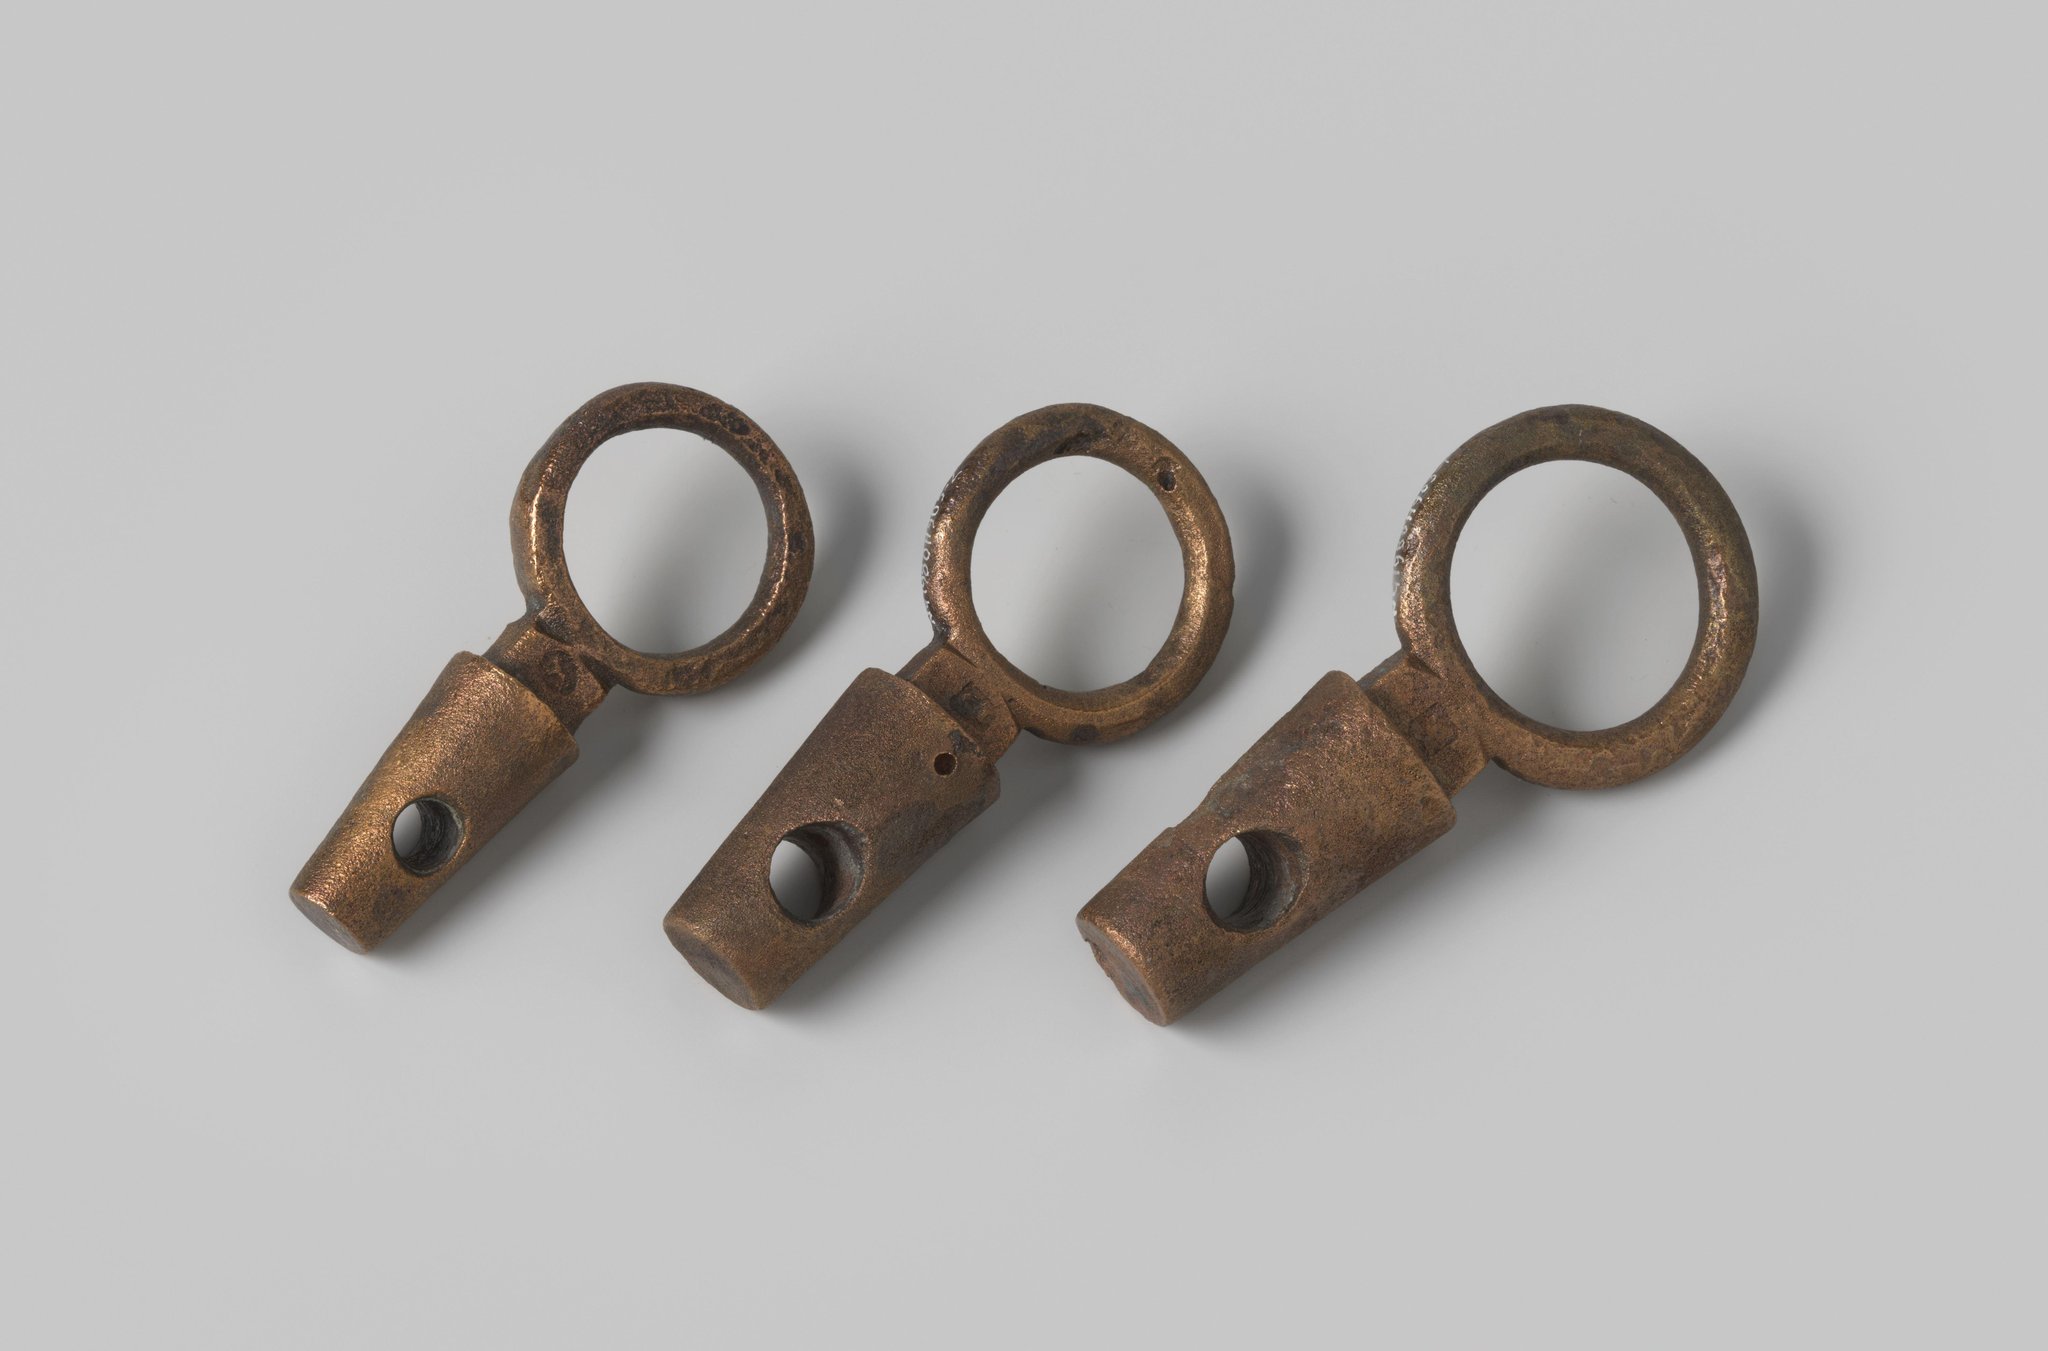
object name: spigot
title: Tapkranen uit het wrak van de Oost-Indiëvaarder Hollandia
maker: Anonymous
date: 1700-1743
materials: copper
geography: netherlands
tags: verenigde oostindische compagnie, hollandia (schip), annet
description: Tap, spigot, removable; consisting of tapering cylinder with circular, ring-shaped handle, circular drainage-hole, arrester lugs missing, marks id. NG 1979-523H, partly legible.